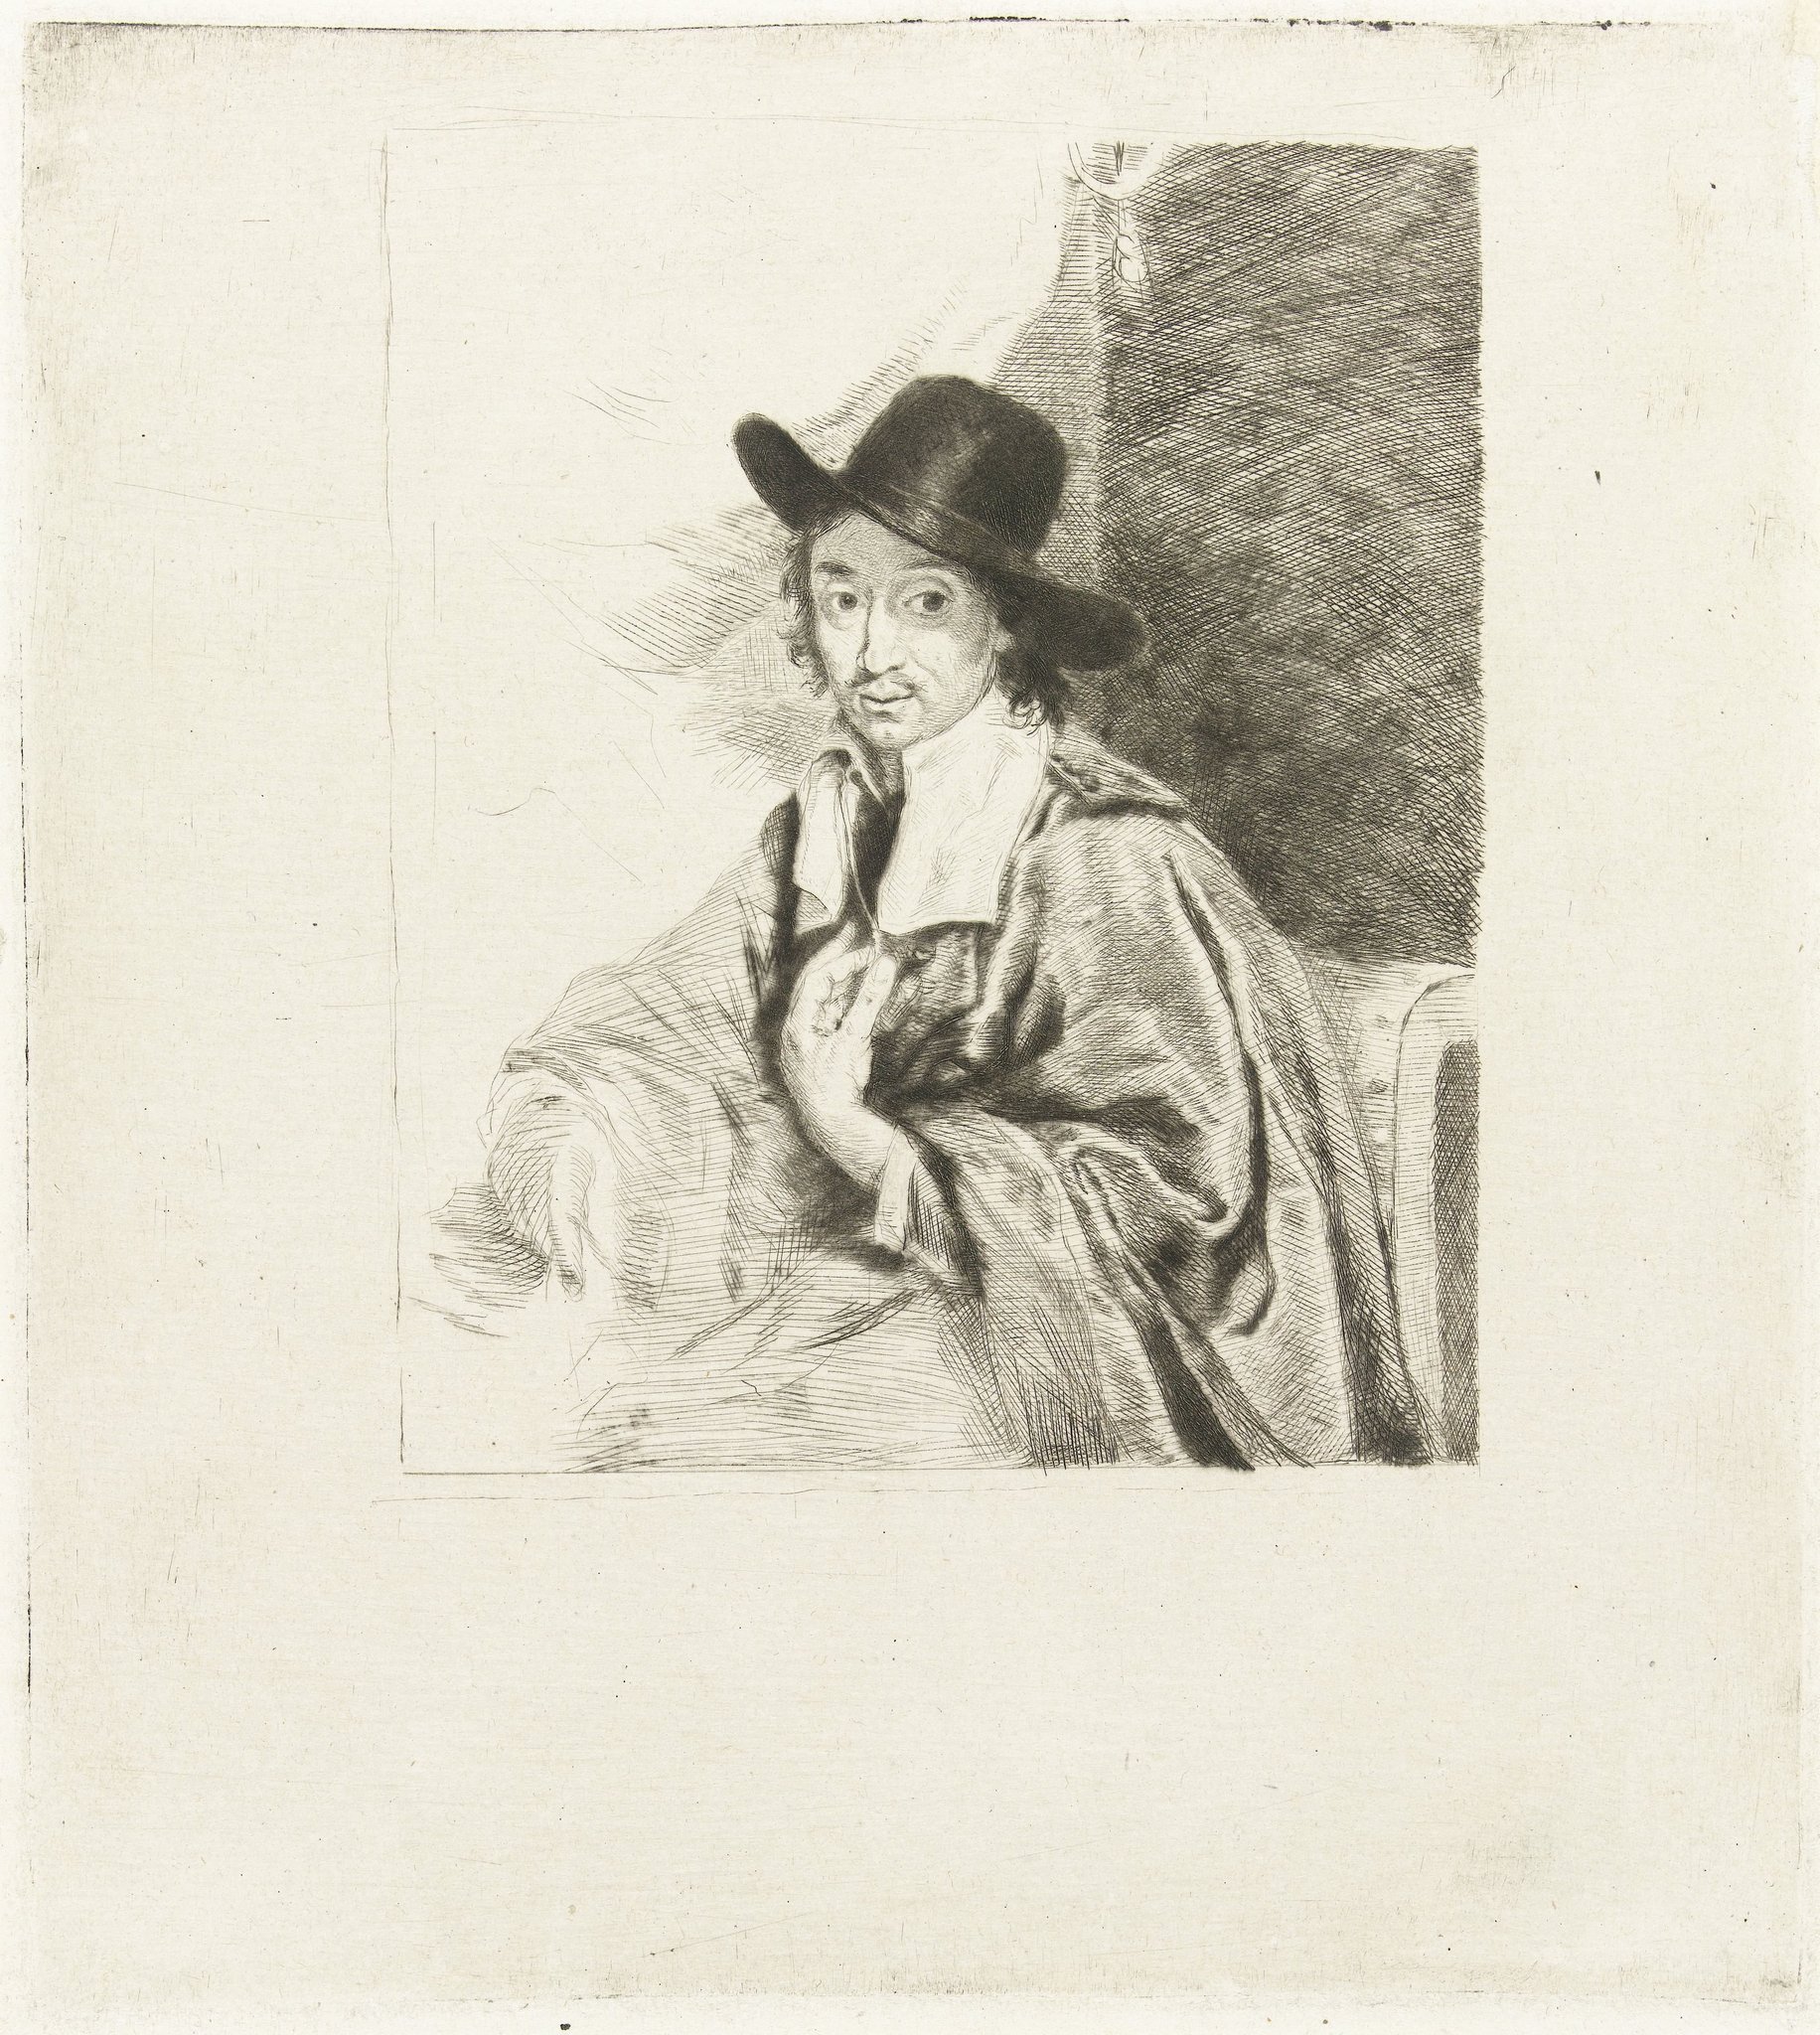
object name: print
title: Portret van de schilder Adriaen van Ostade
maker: louis bernard coclers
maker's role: draughtsman, print maker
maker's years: 1741-1817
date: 1756-1817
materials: paper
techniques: drypoint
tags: haarlem, painter, print maker, draughtsman, adriaen van ostade, portrait, self-portrait of artist (+ artist in non-work situation)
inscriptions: collector's mark: Lugt 2228